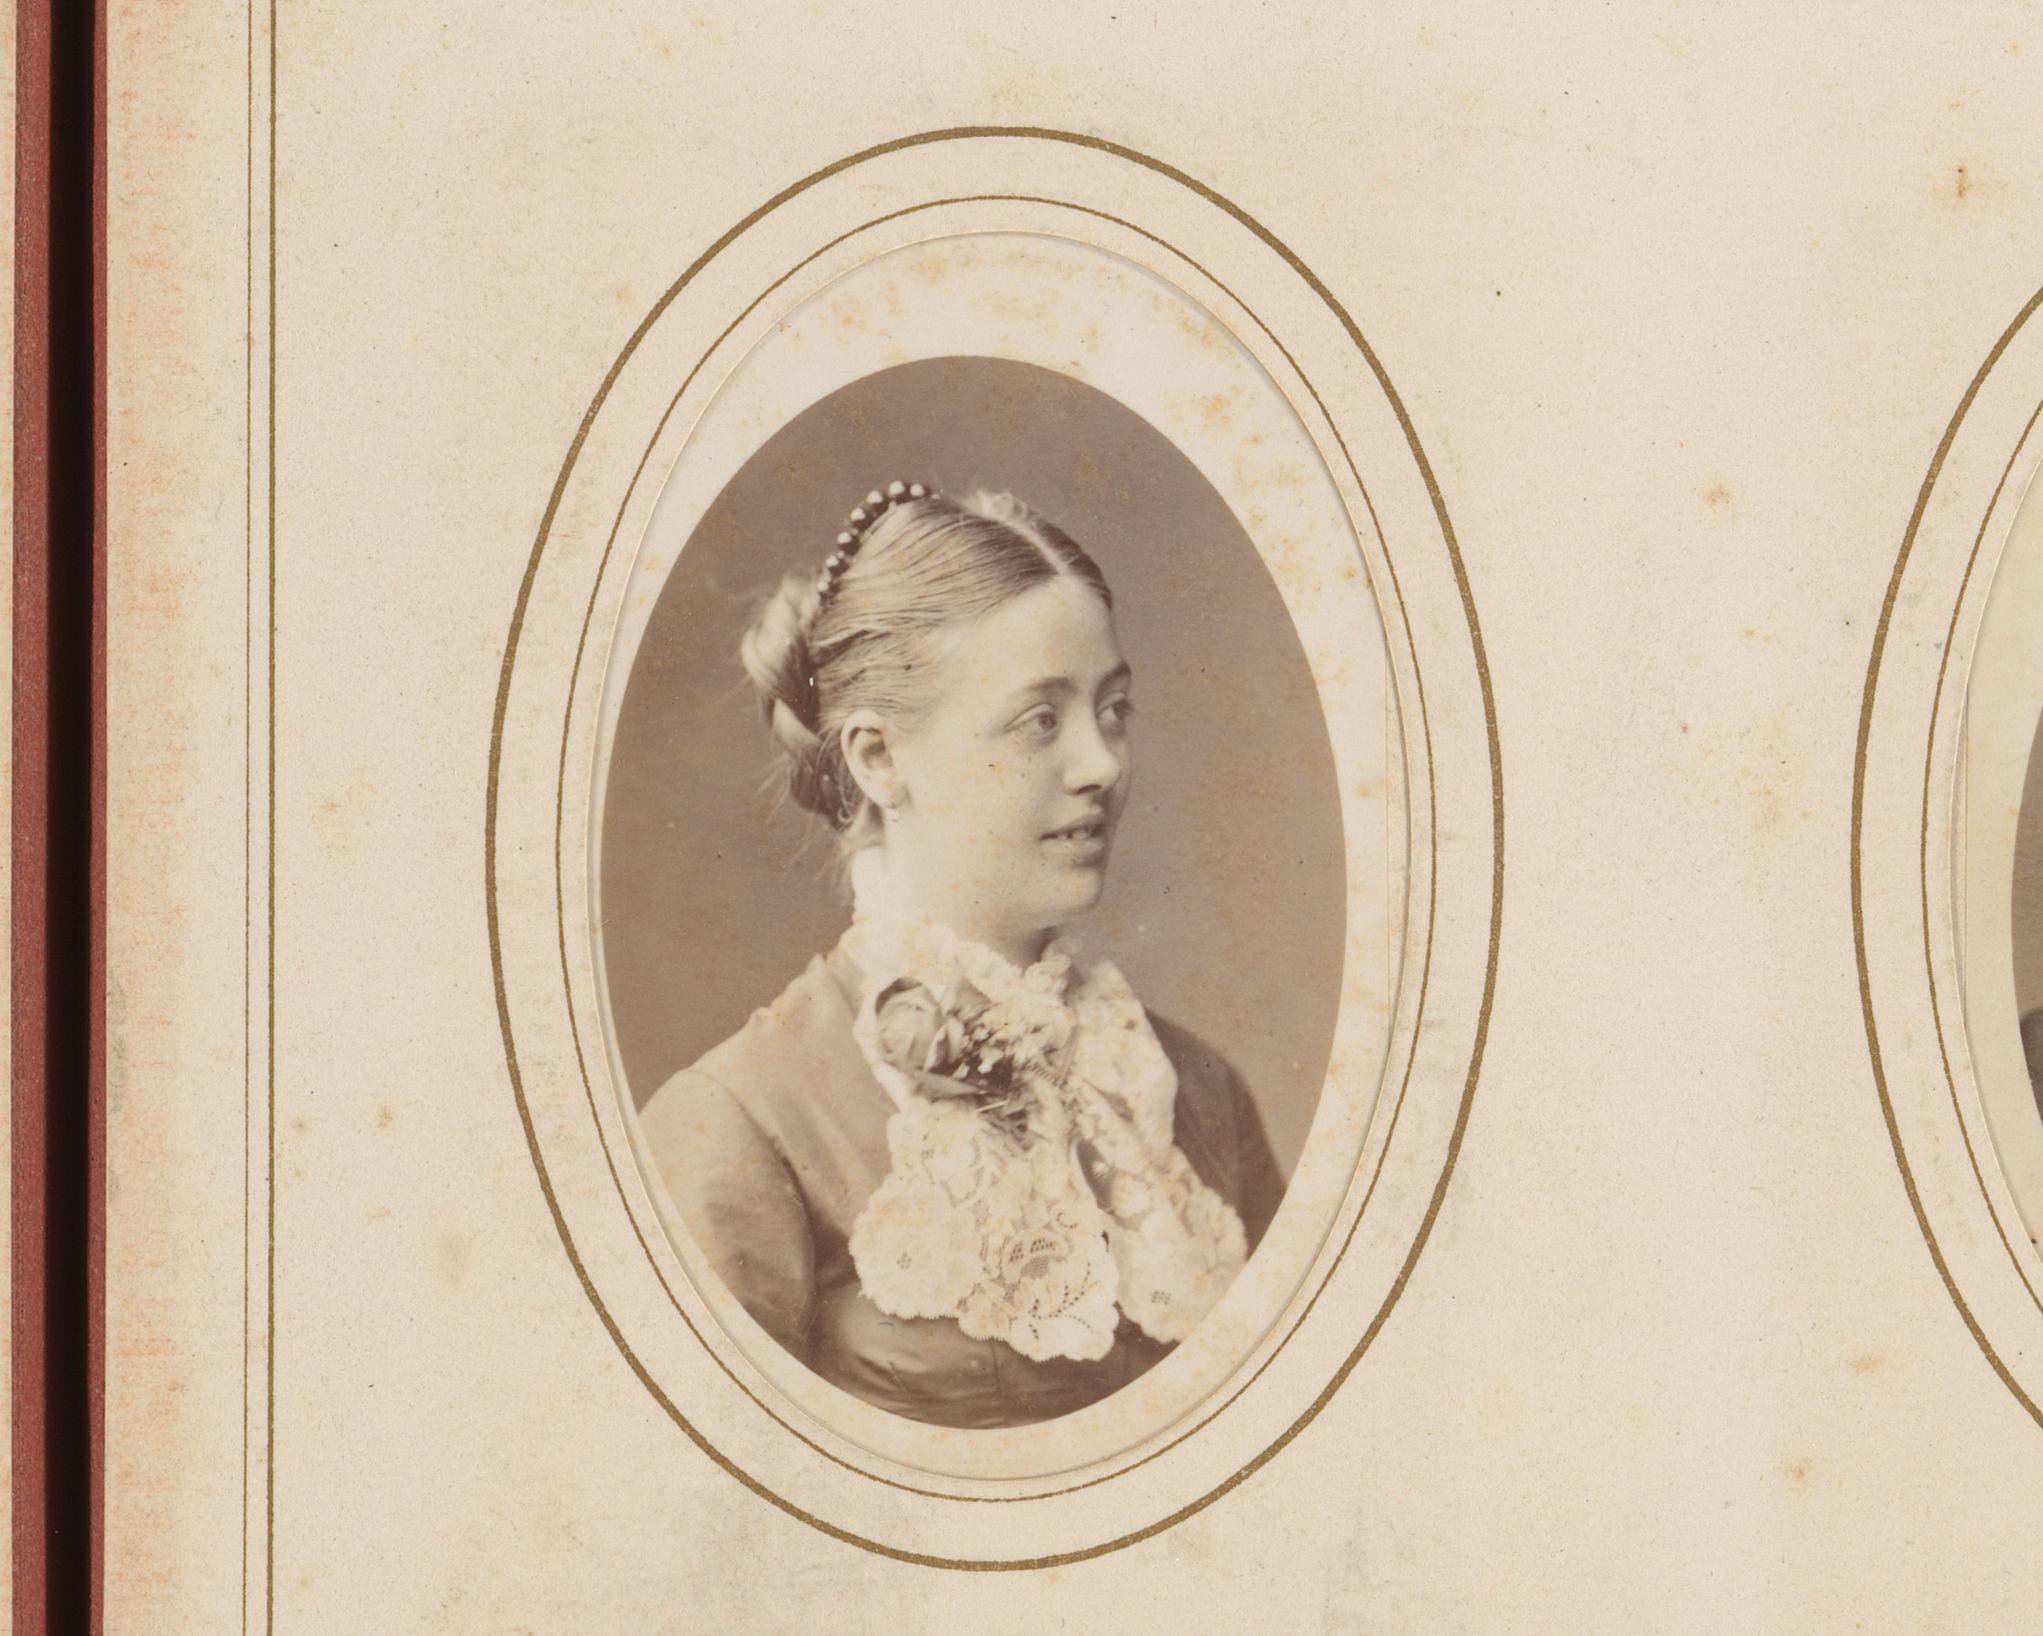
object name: album leaf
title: Portret van een jonge vrouw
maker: theodor prümm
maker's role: fotograaf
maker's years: 1841-1890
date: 1880-1900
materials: cardboard, photographic support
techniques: albumen print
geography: amsterdam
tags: adolescent, young woman, maiden, historical persons - bb - woman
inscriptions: inscription: ‘Inhaber der Preismedaillen/ WIEN/ 1873./ BERLIN/ 1865./ HAMBURG/ 1868./ THEODOR PRÜMM/ BERLIN/ Unter den Linden 51./ 1880./ Platten werden aufbewahrt’